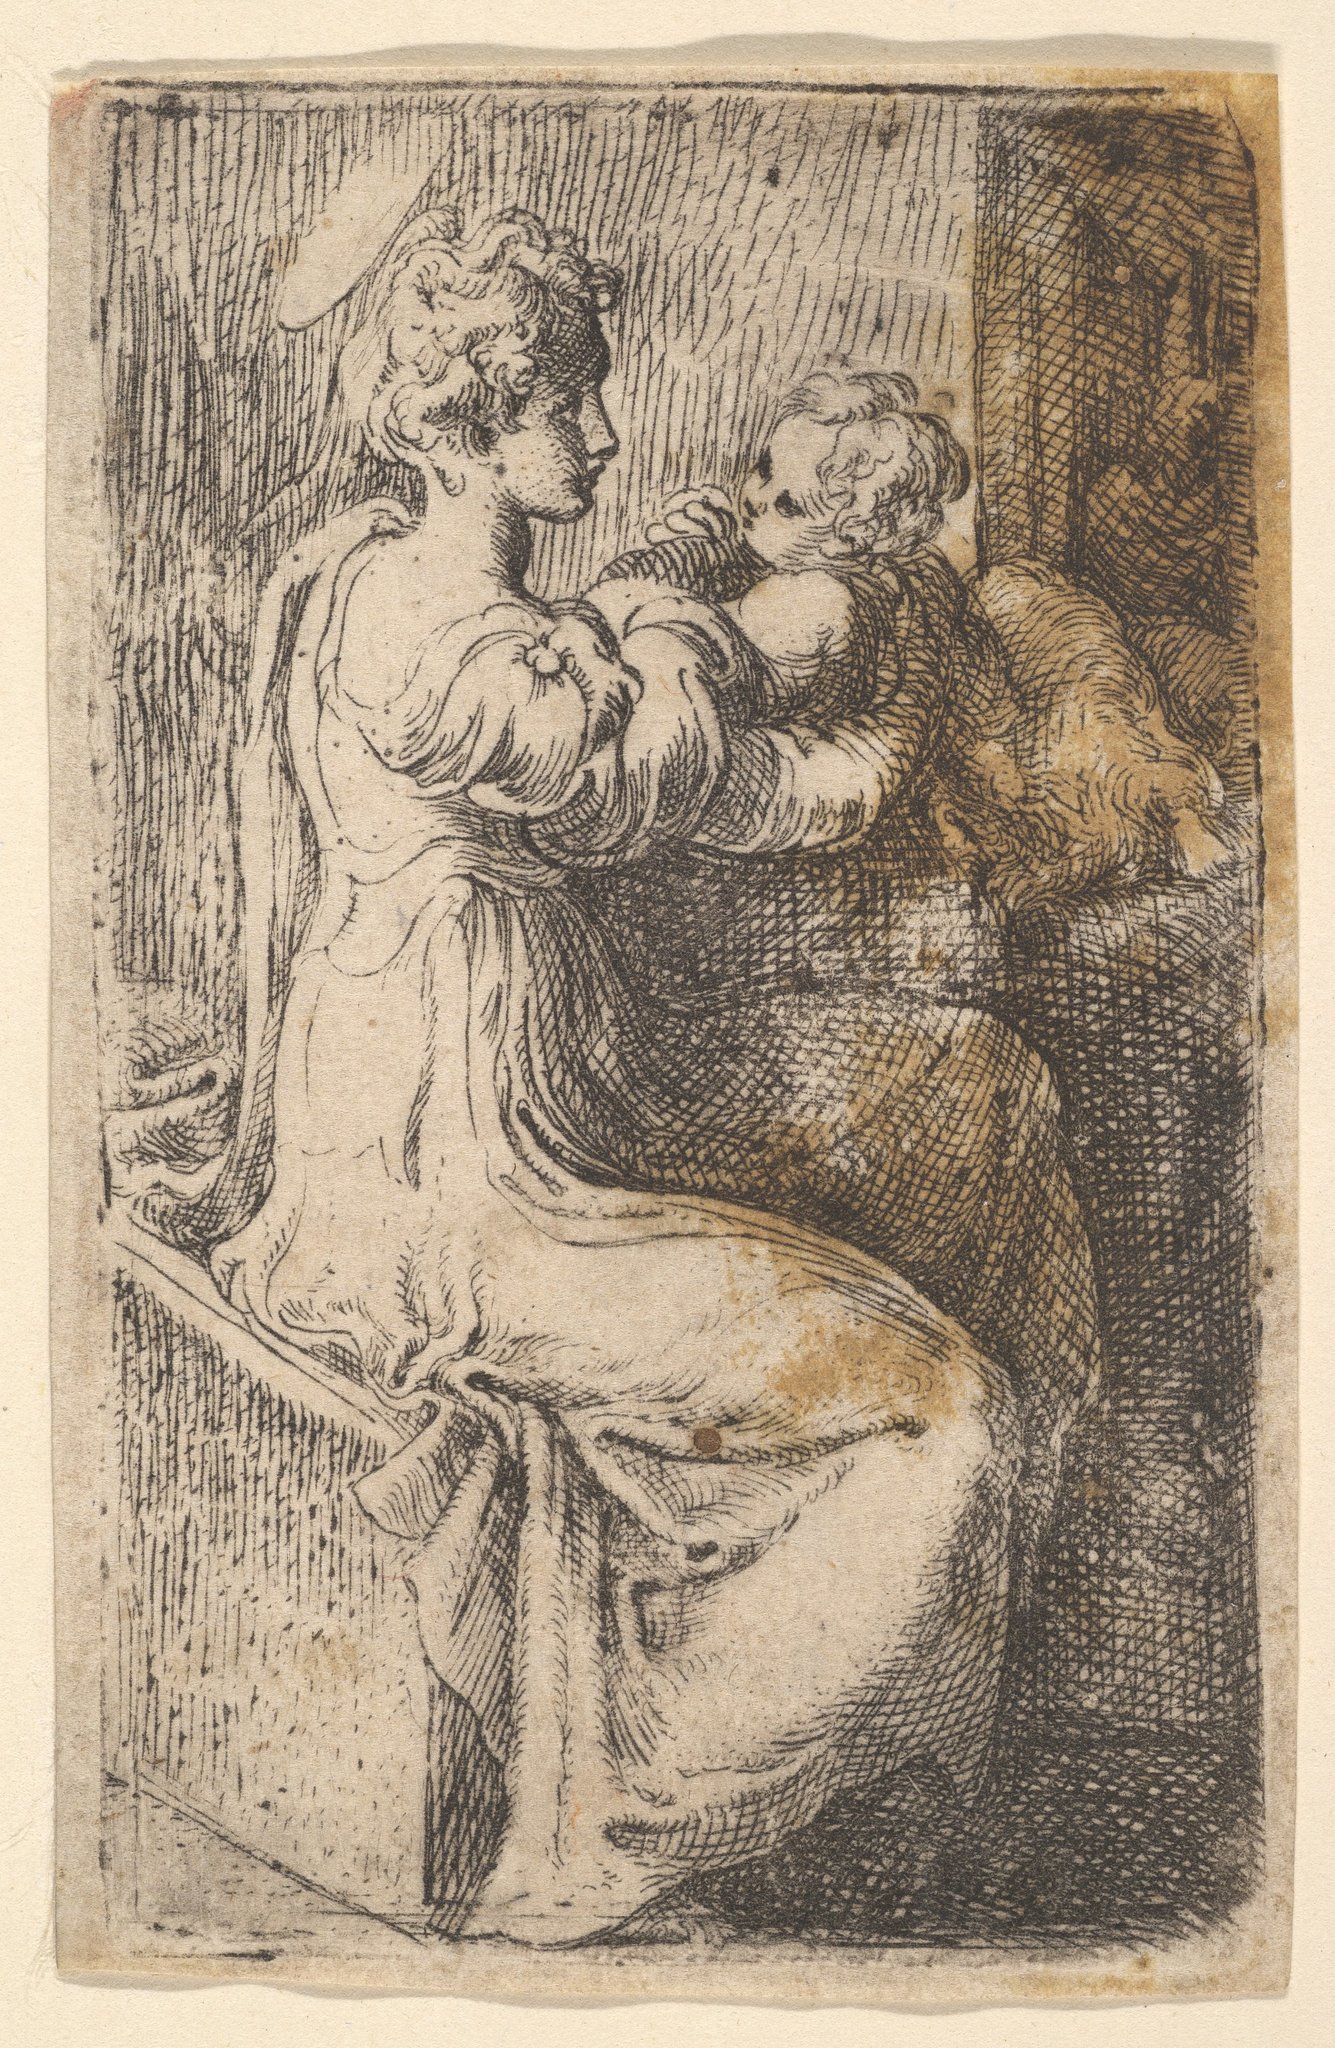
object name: print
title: Virgin and Child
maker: parmigianino (girolamo francesco maria mazzola)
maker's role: artist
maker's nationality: italian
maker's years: 1503-1540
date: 1501-1533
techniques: etching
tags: madonna and child